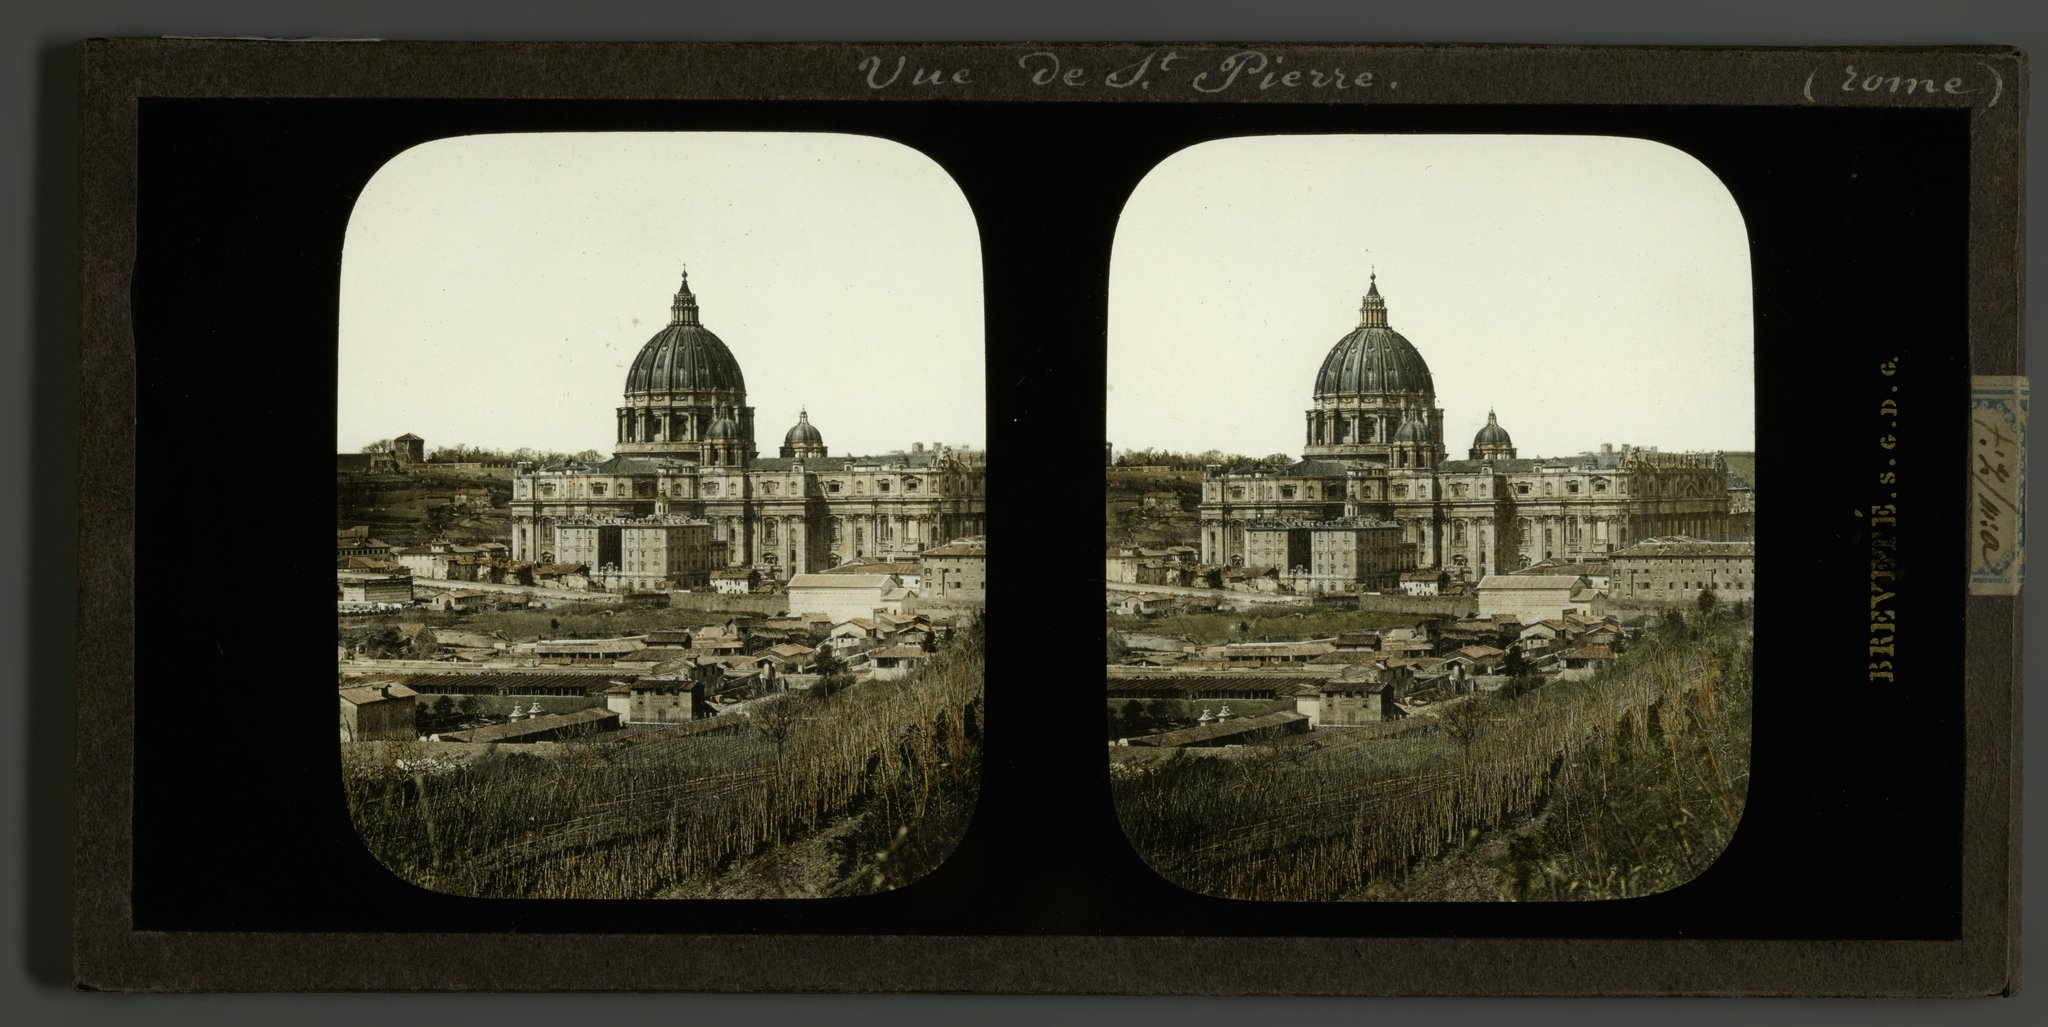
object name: stereoscopic photograph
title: Gezicht op de Sint-Pietersbasiliek te Rome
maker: Anonymous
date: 1856-1868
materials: glass, paper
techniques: hand coloring, slide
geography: rome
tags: church (exterior)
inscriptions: annotation: ‘t:z/m:a’, inscription: ‘Breveté. s.g.d.g.’, annotation: ‘Vue de St. Pierre (rome)’